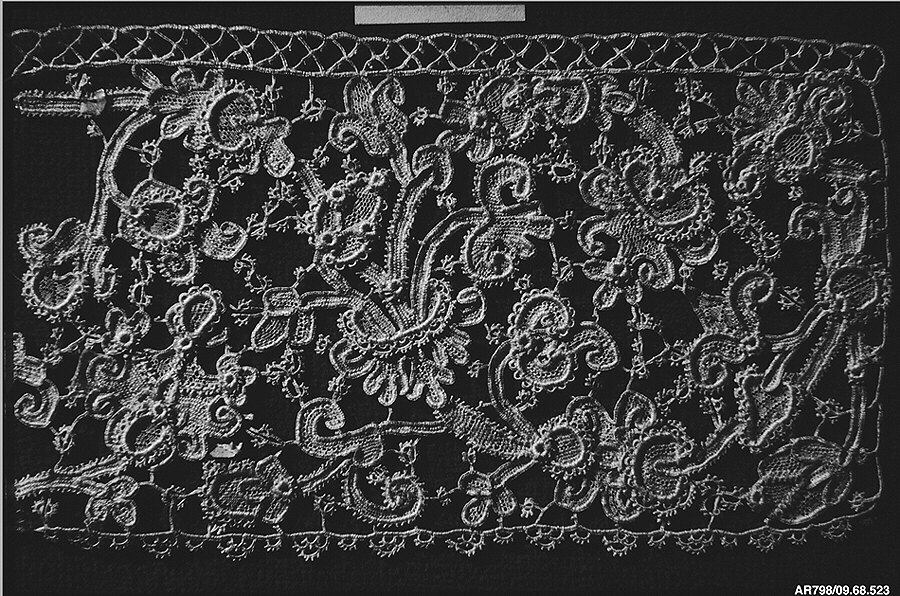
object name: fragment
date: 1801-1900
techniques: lace